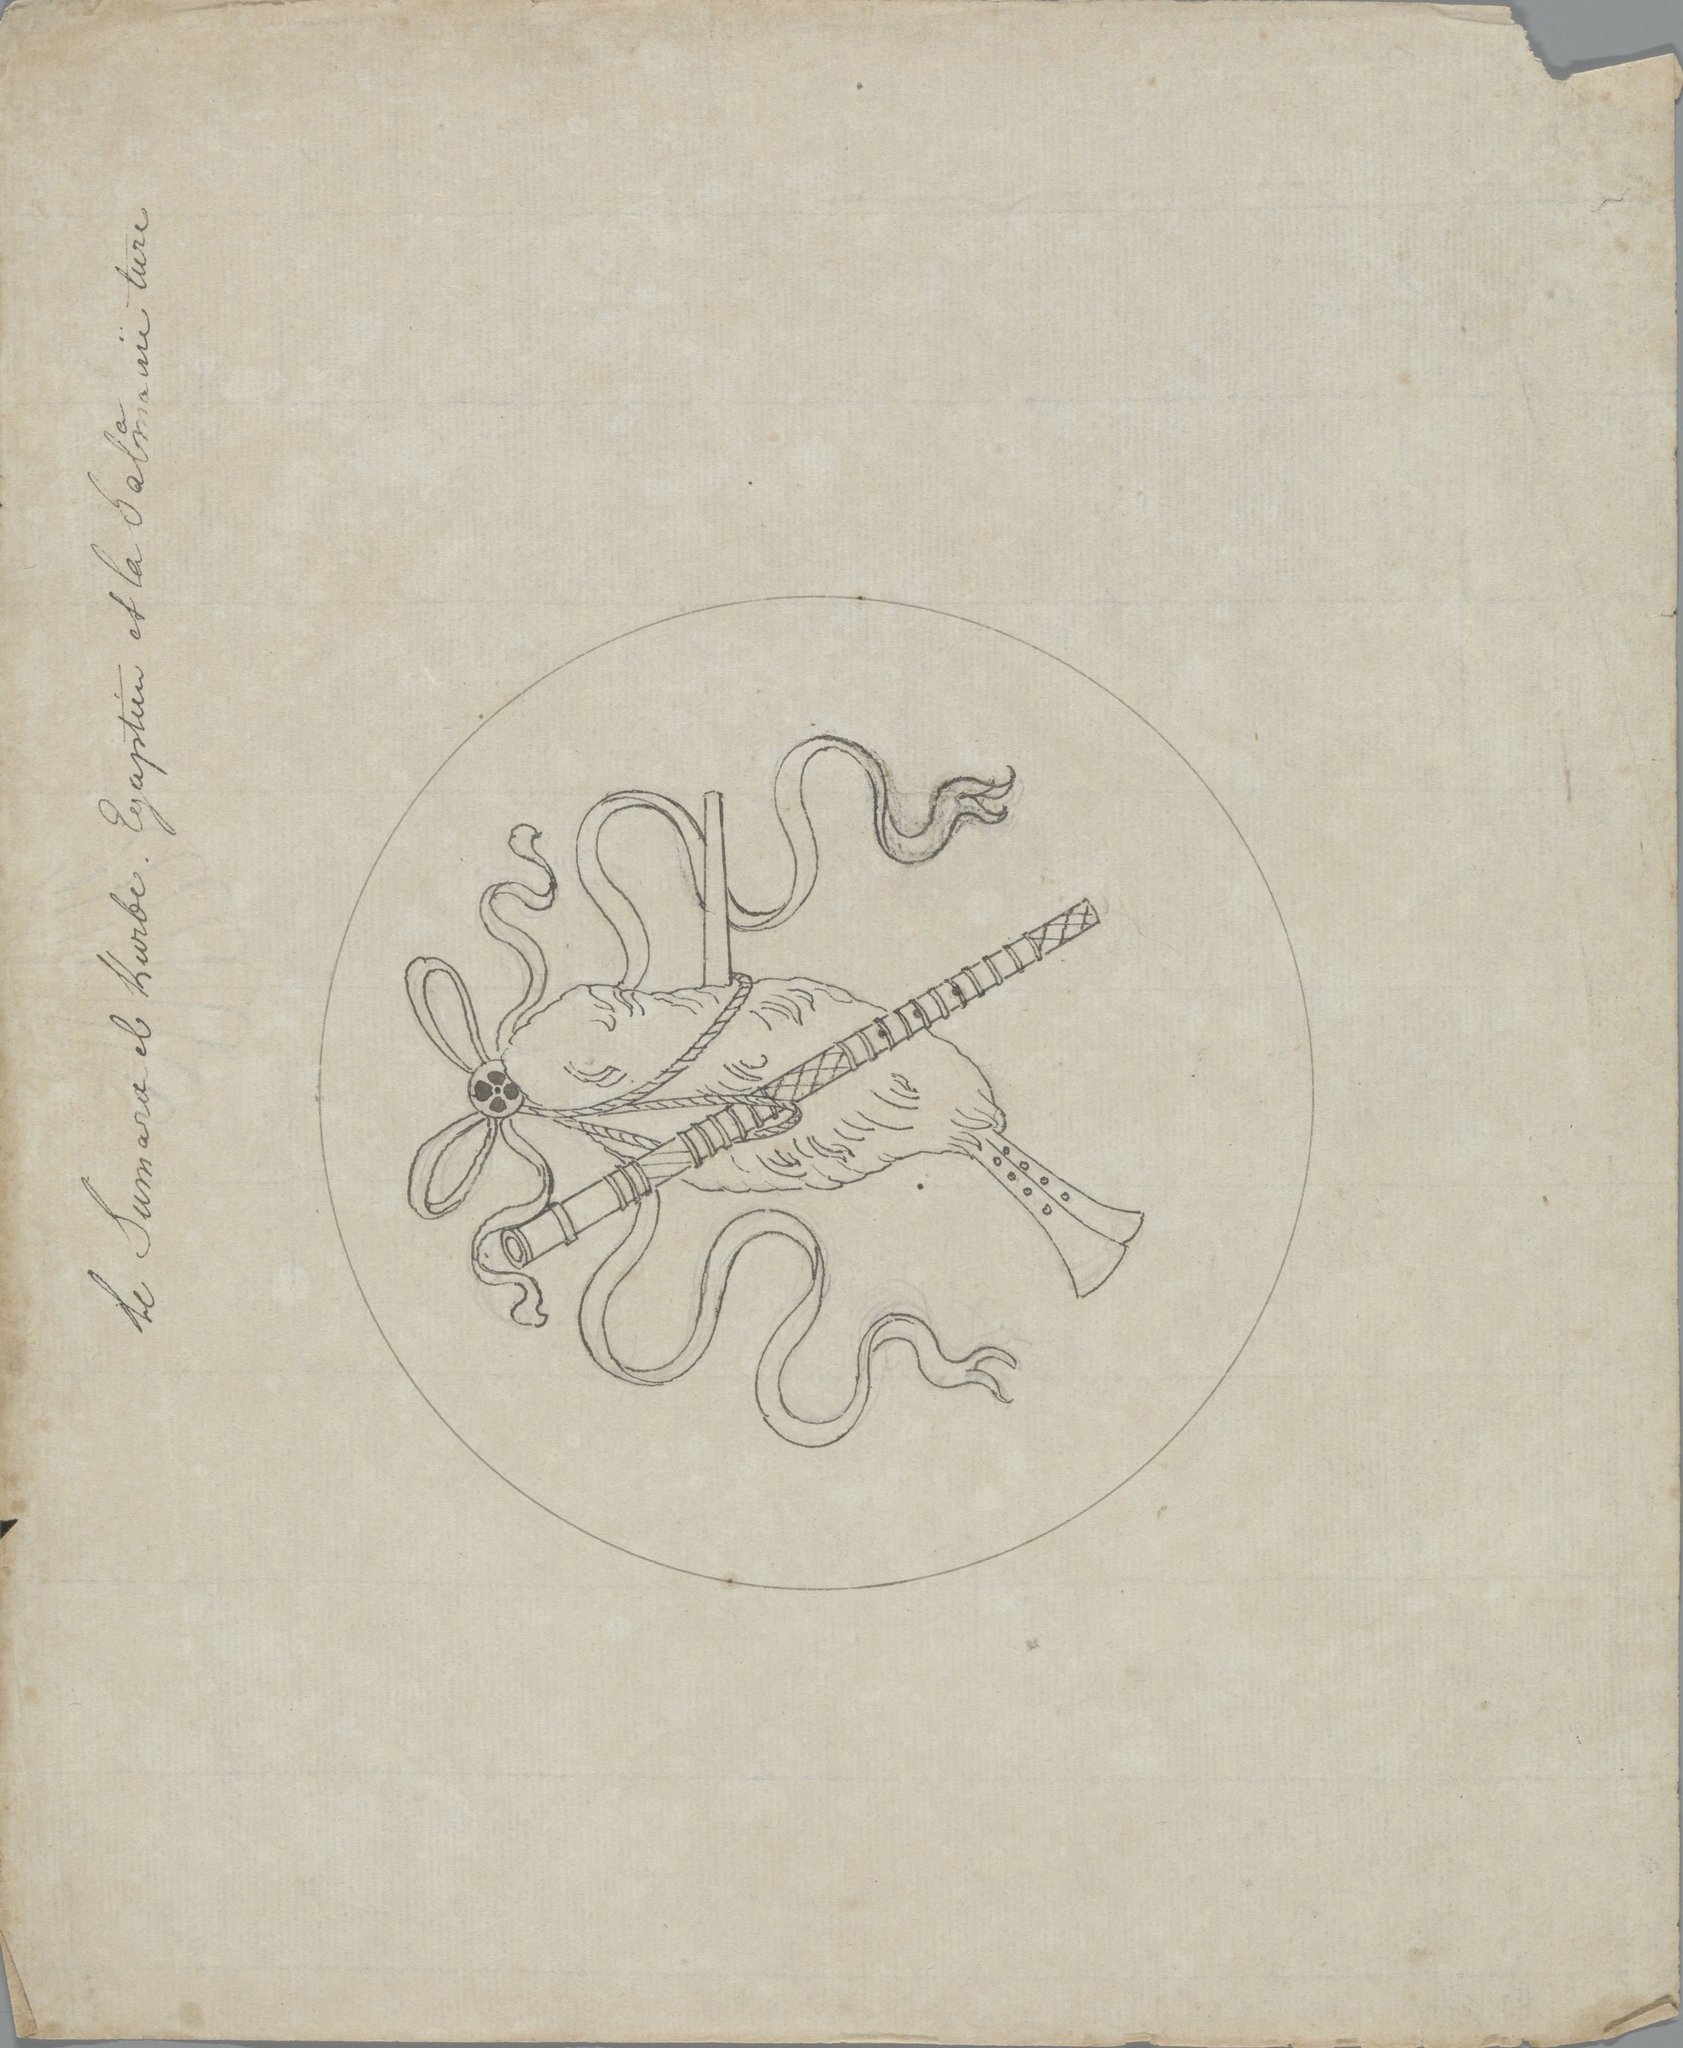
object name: design drawing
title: Le Samara el Kurbe Egyptien et la halamanie turc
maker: pierre félix van doren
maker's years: 1797-1856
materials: graphite, ink, paper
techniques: pen in black ink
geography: brussels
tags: trophy, i.e.: decorative arrangement of symbolic or typical objects ~ ornament, bagpipe, musette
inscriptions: inscription: ‘Le Samara el Kurbe Egyptien et la halamanie turc’, watermark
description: Een van 103 ontwerpen voor marqueterie van aan linten opgehangen muziekinstrumenten in ronde medaillons, bestemd voor de set stoelen gemaakt door Van Doren voor de grote zaal van het Paleis van de Prins van Oranje in Brussel in 1828.